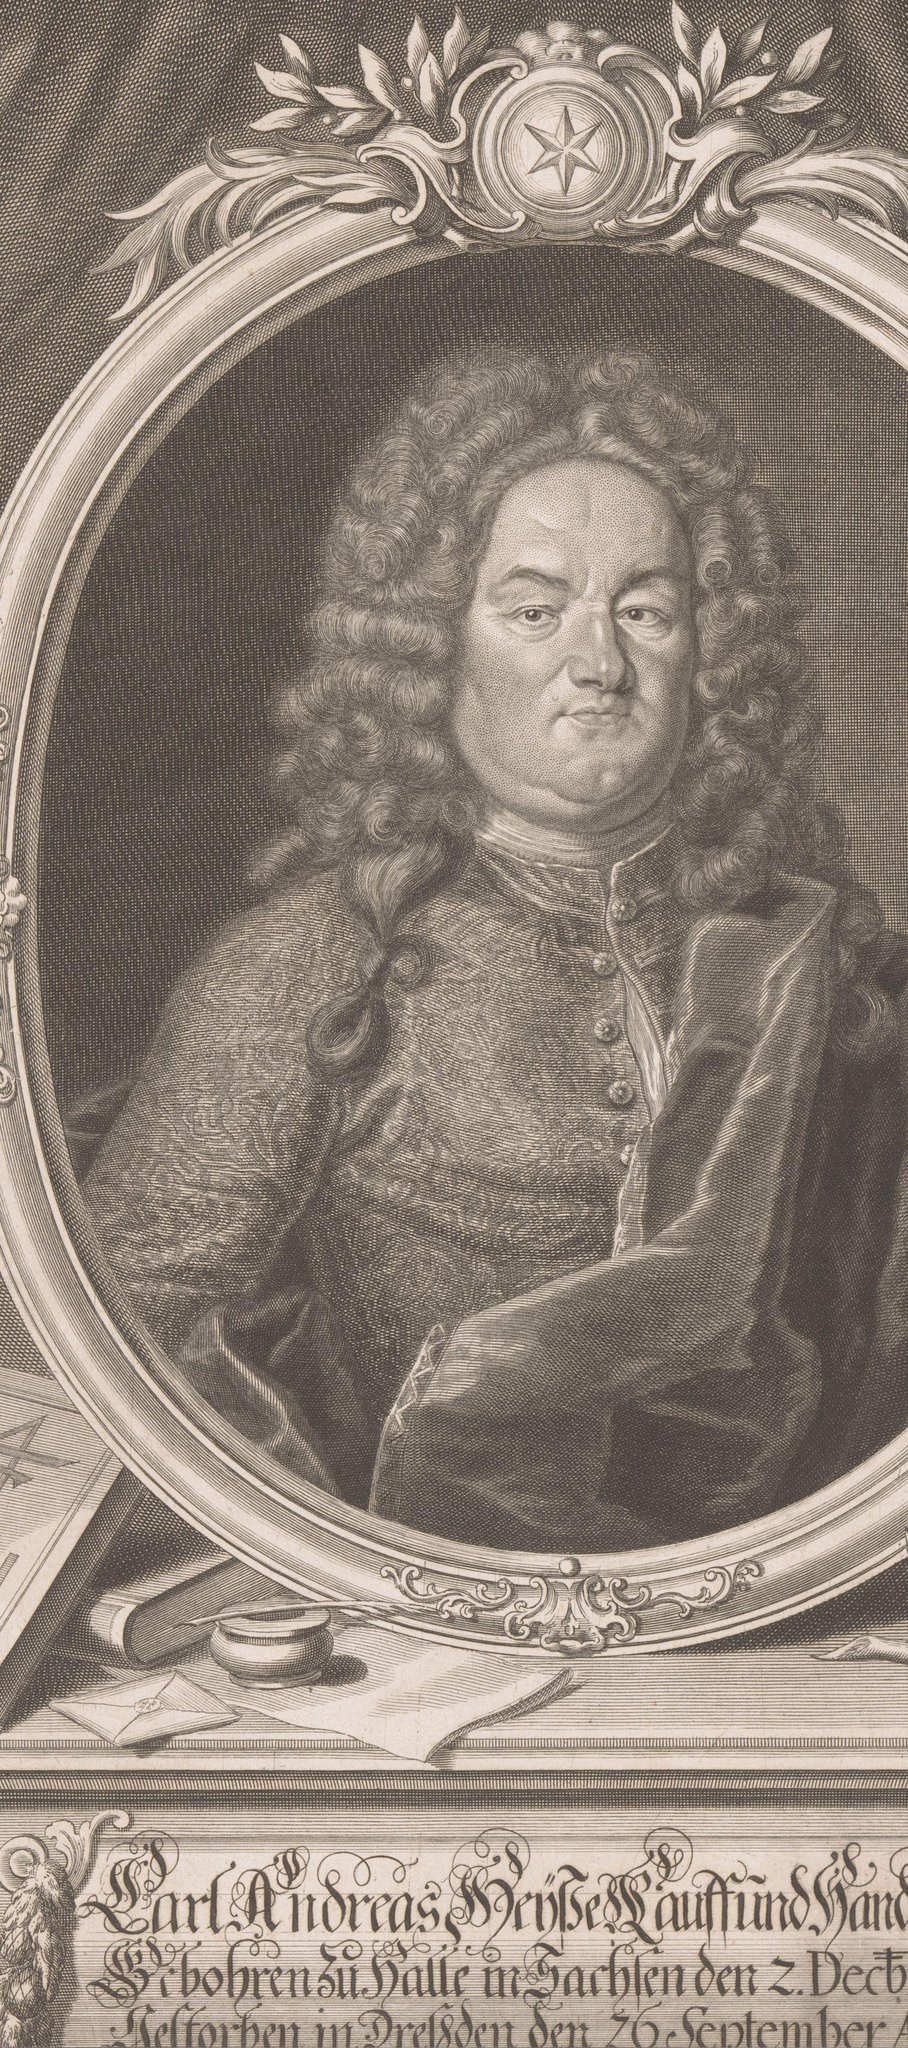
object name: print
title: Portret van Friedrich Wilhelm Herold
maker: johann georg wolfgang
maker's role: graveur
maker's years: 1662-1744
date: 1739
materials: paper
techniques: engraving, etching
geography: berlin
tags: mayor, historical persons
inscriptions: inscription: ‘Herold Fried. Wilhelm’, collector's mark: Lugt 2228, number: ‘50’